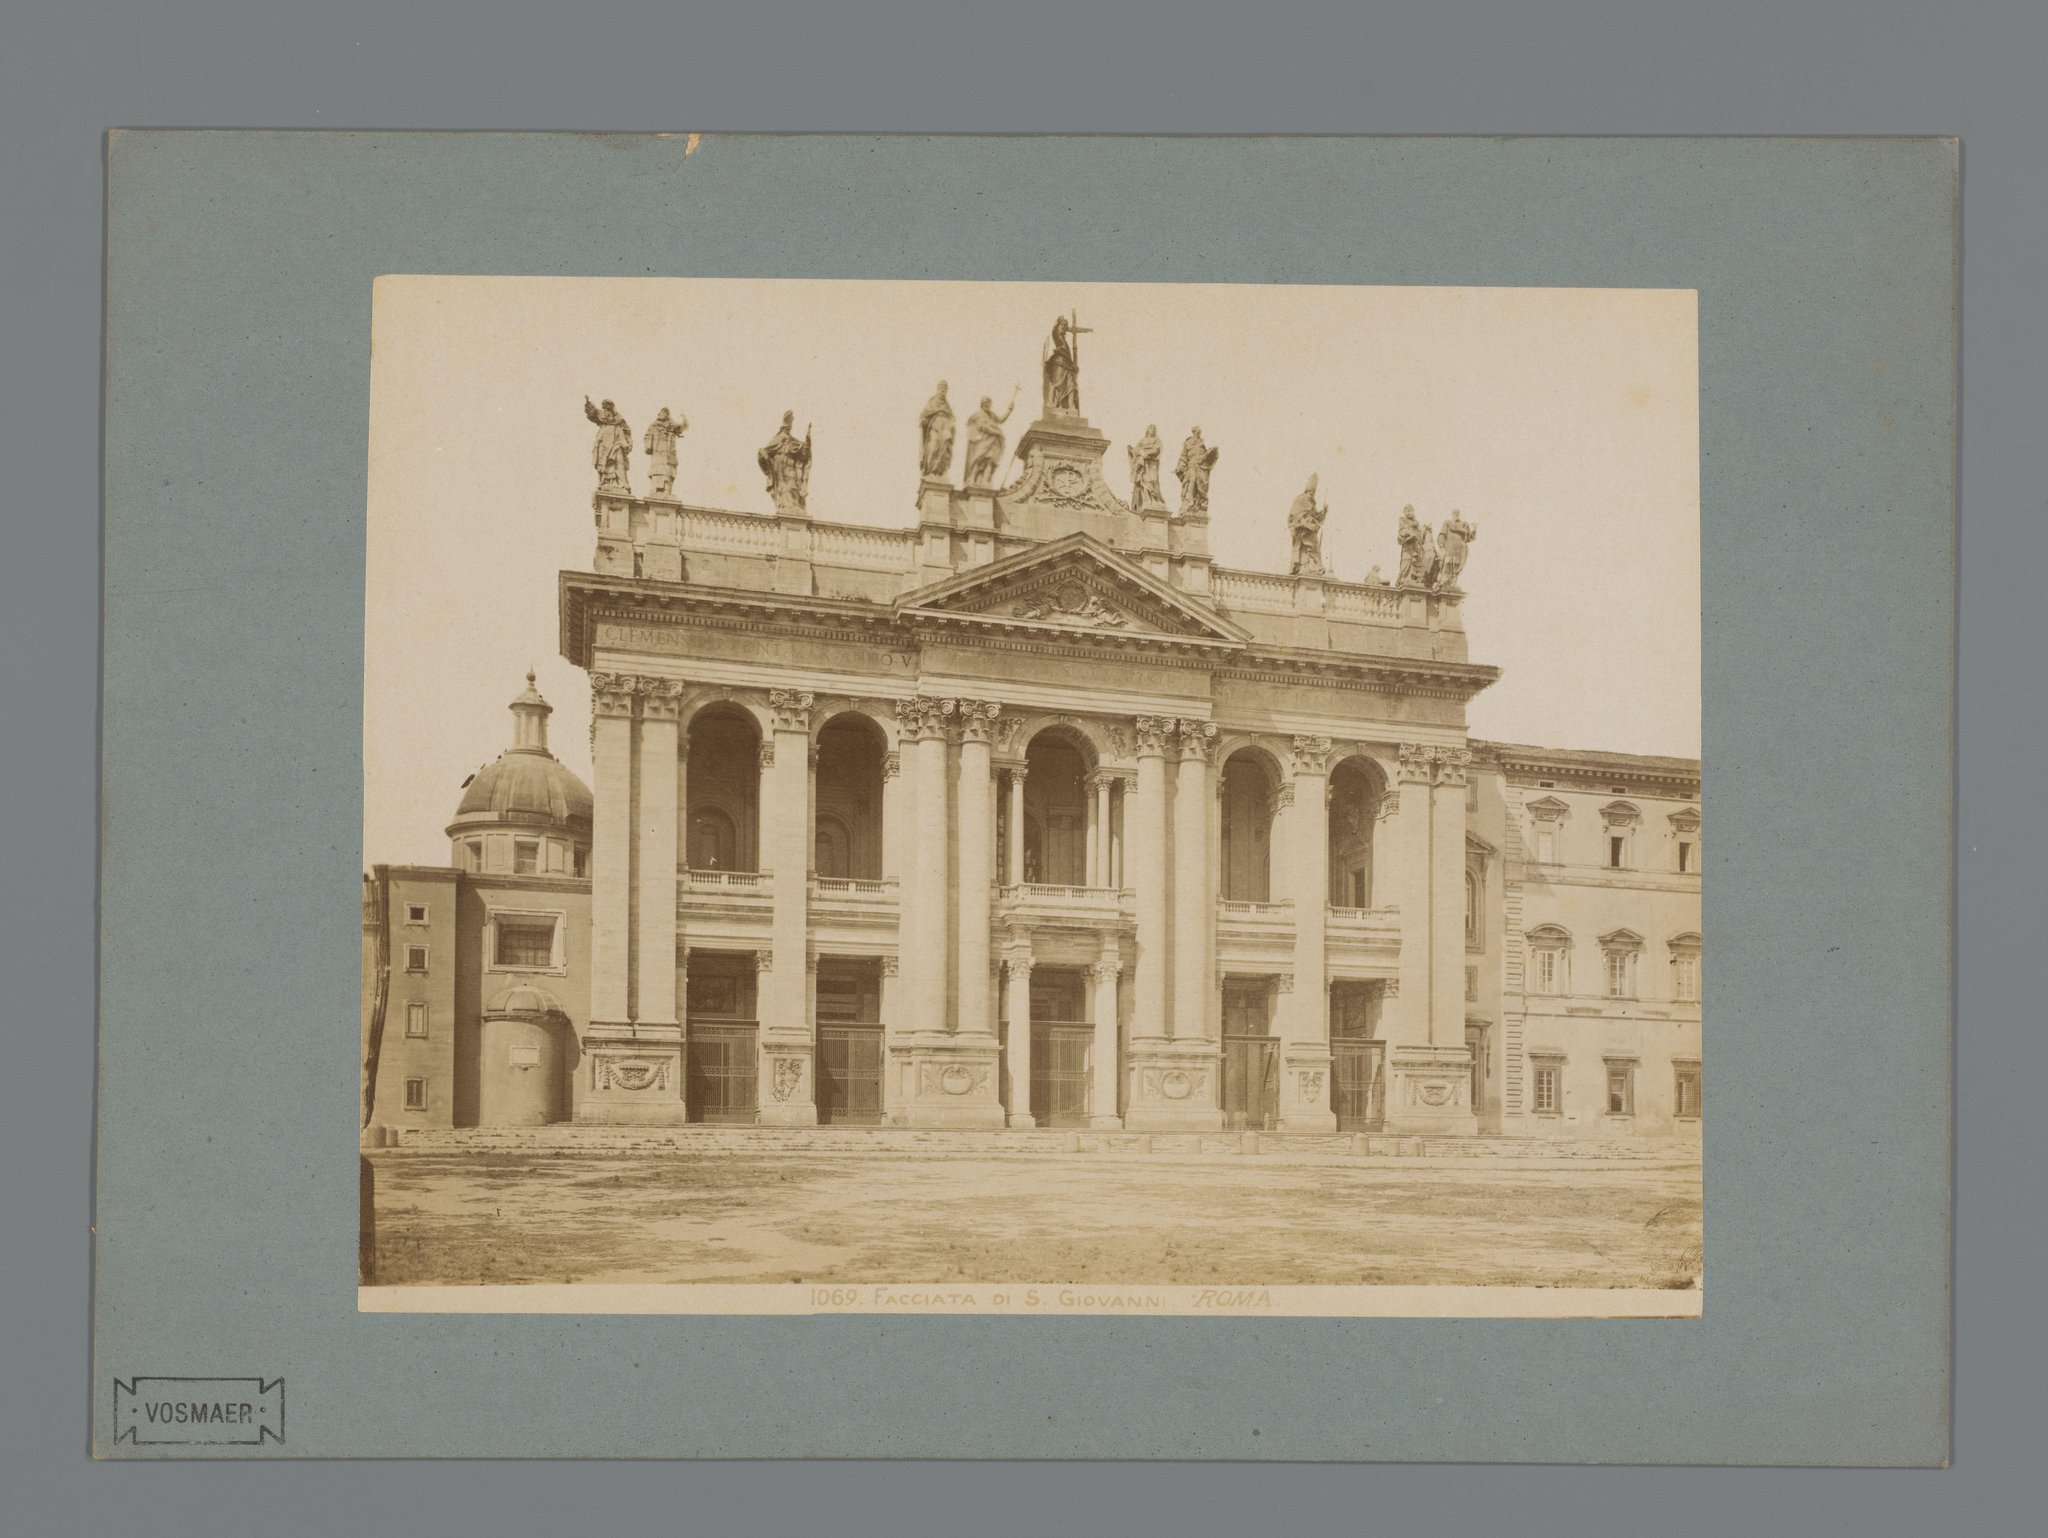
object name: photograph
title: Façade van de Sint-Jan van Lateranen te Rome, Italië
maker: Anonymous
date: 1851-1890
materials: cardboard, paper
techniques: albumen print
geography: rome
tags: parts of church exterior and annexes: façade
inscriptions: number: ‘1069.’, collector's mark: ‘VOSMAER’